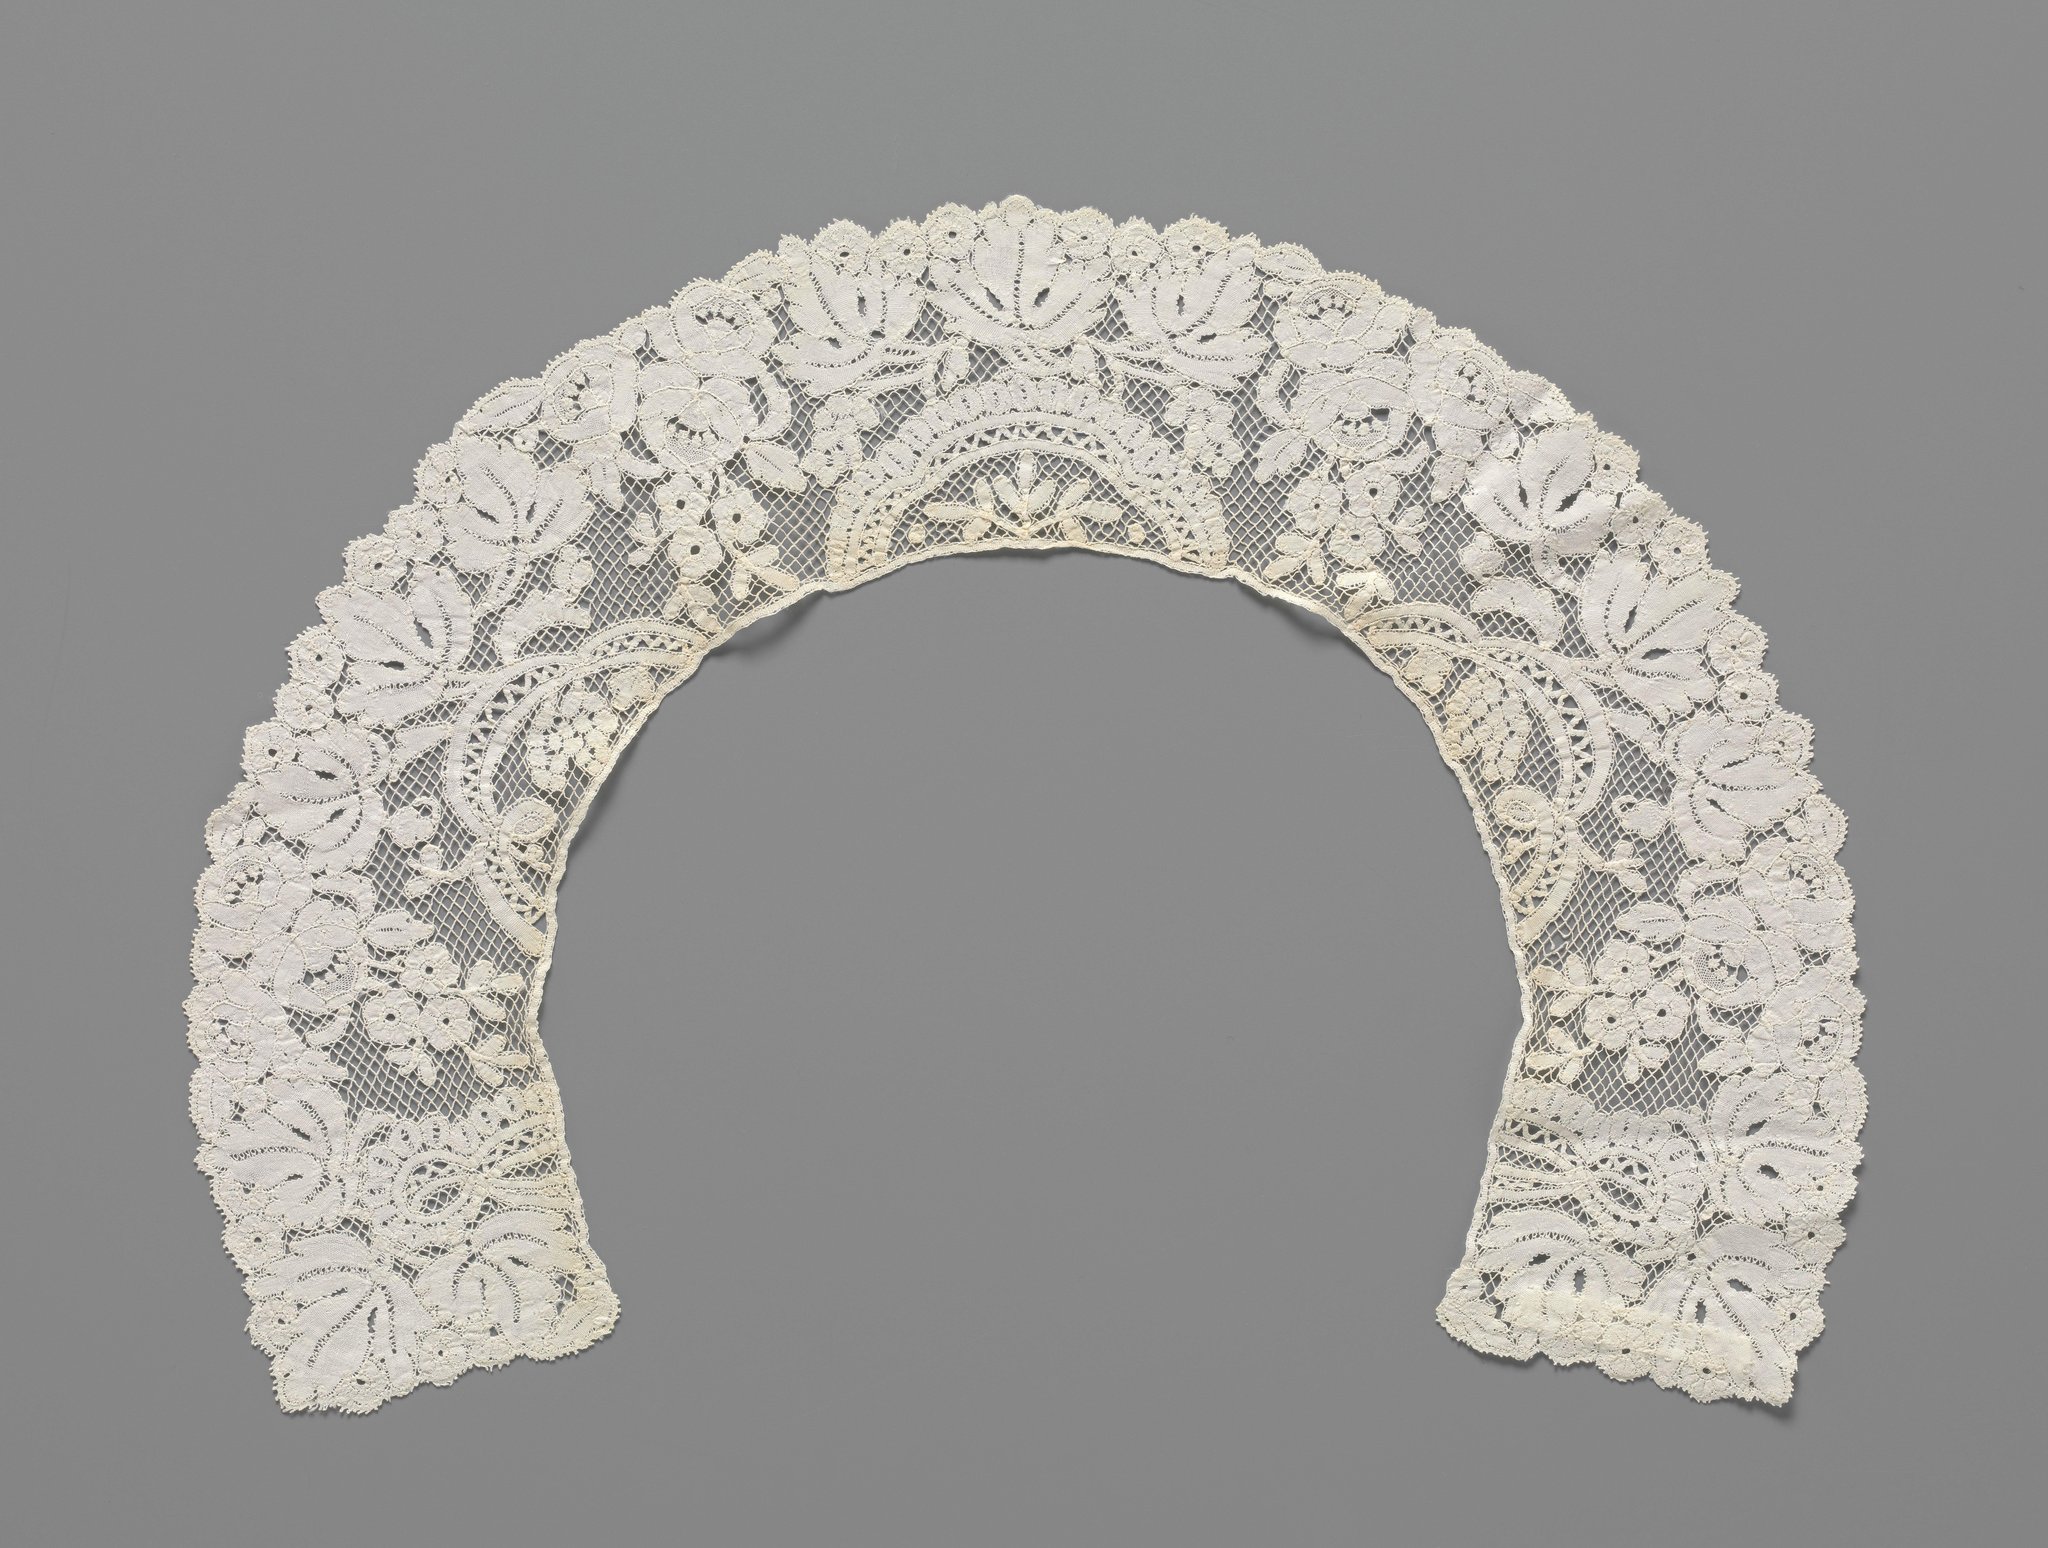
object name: clothing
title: Kraag van kloskant met wingerdbladeren en rozen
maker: Anonymous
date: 1860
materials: linen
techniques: lace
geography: belgium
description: Kraag van naturelkleurige kloskant: Brabantse Valenciennes-kant. Half cirkelvormig model. Het patroon heeft aan de buitenzijde en de uiteinden een rand van afwisselend drie wingerdbladeren en drie rozen. Aan de binnenzijde staan onder de wingerdbladeren vijf boogvormige ornamenten met zigzagjes en godrons. De motieven zijn geklost in zeer gesloten linnenslag en zijn met elkaar verbonden door een vierkante Valenciennes-grond.